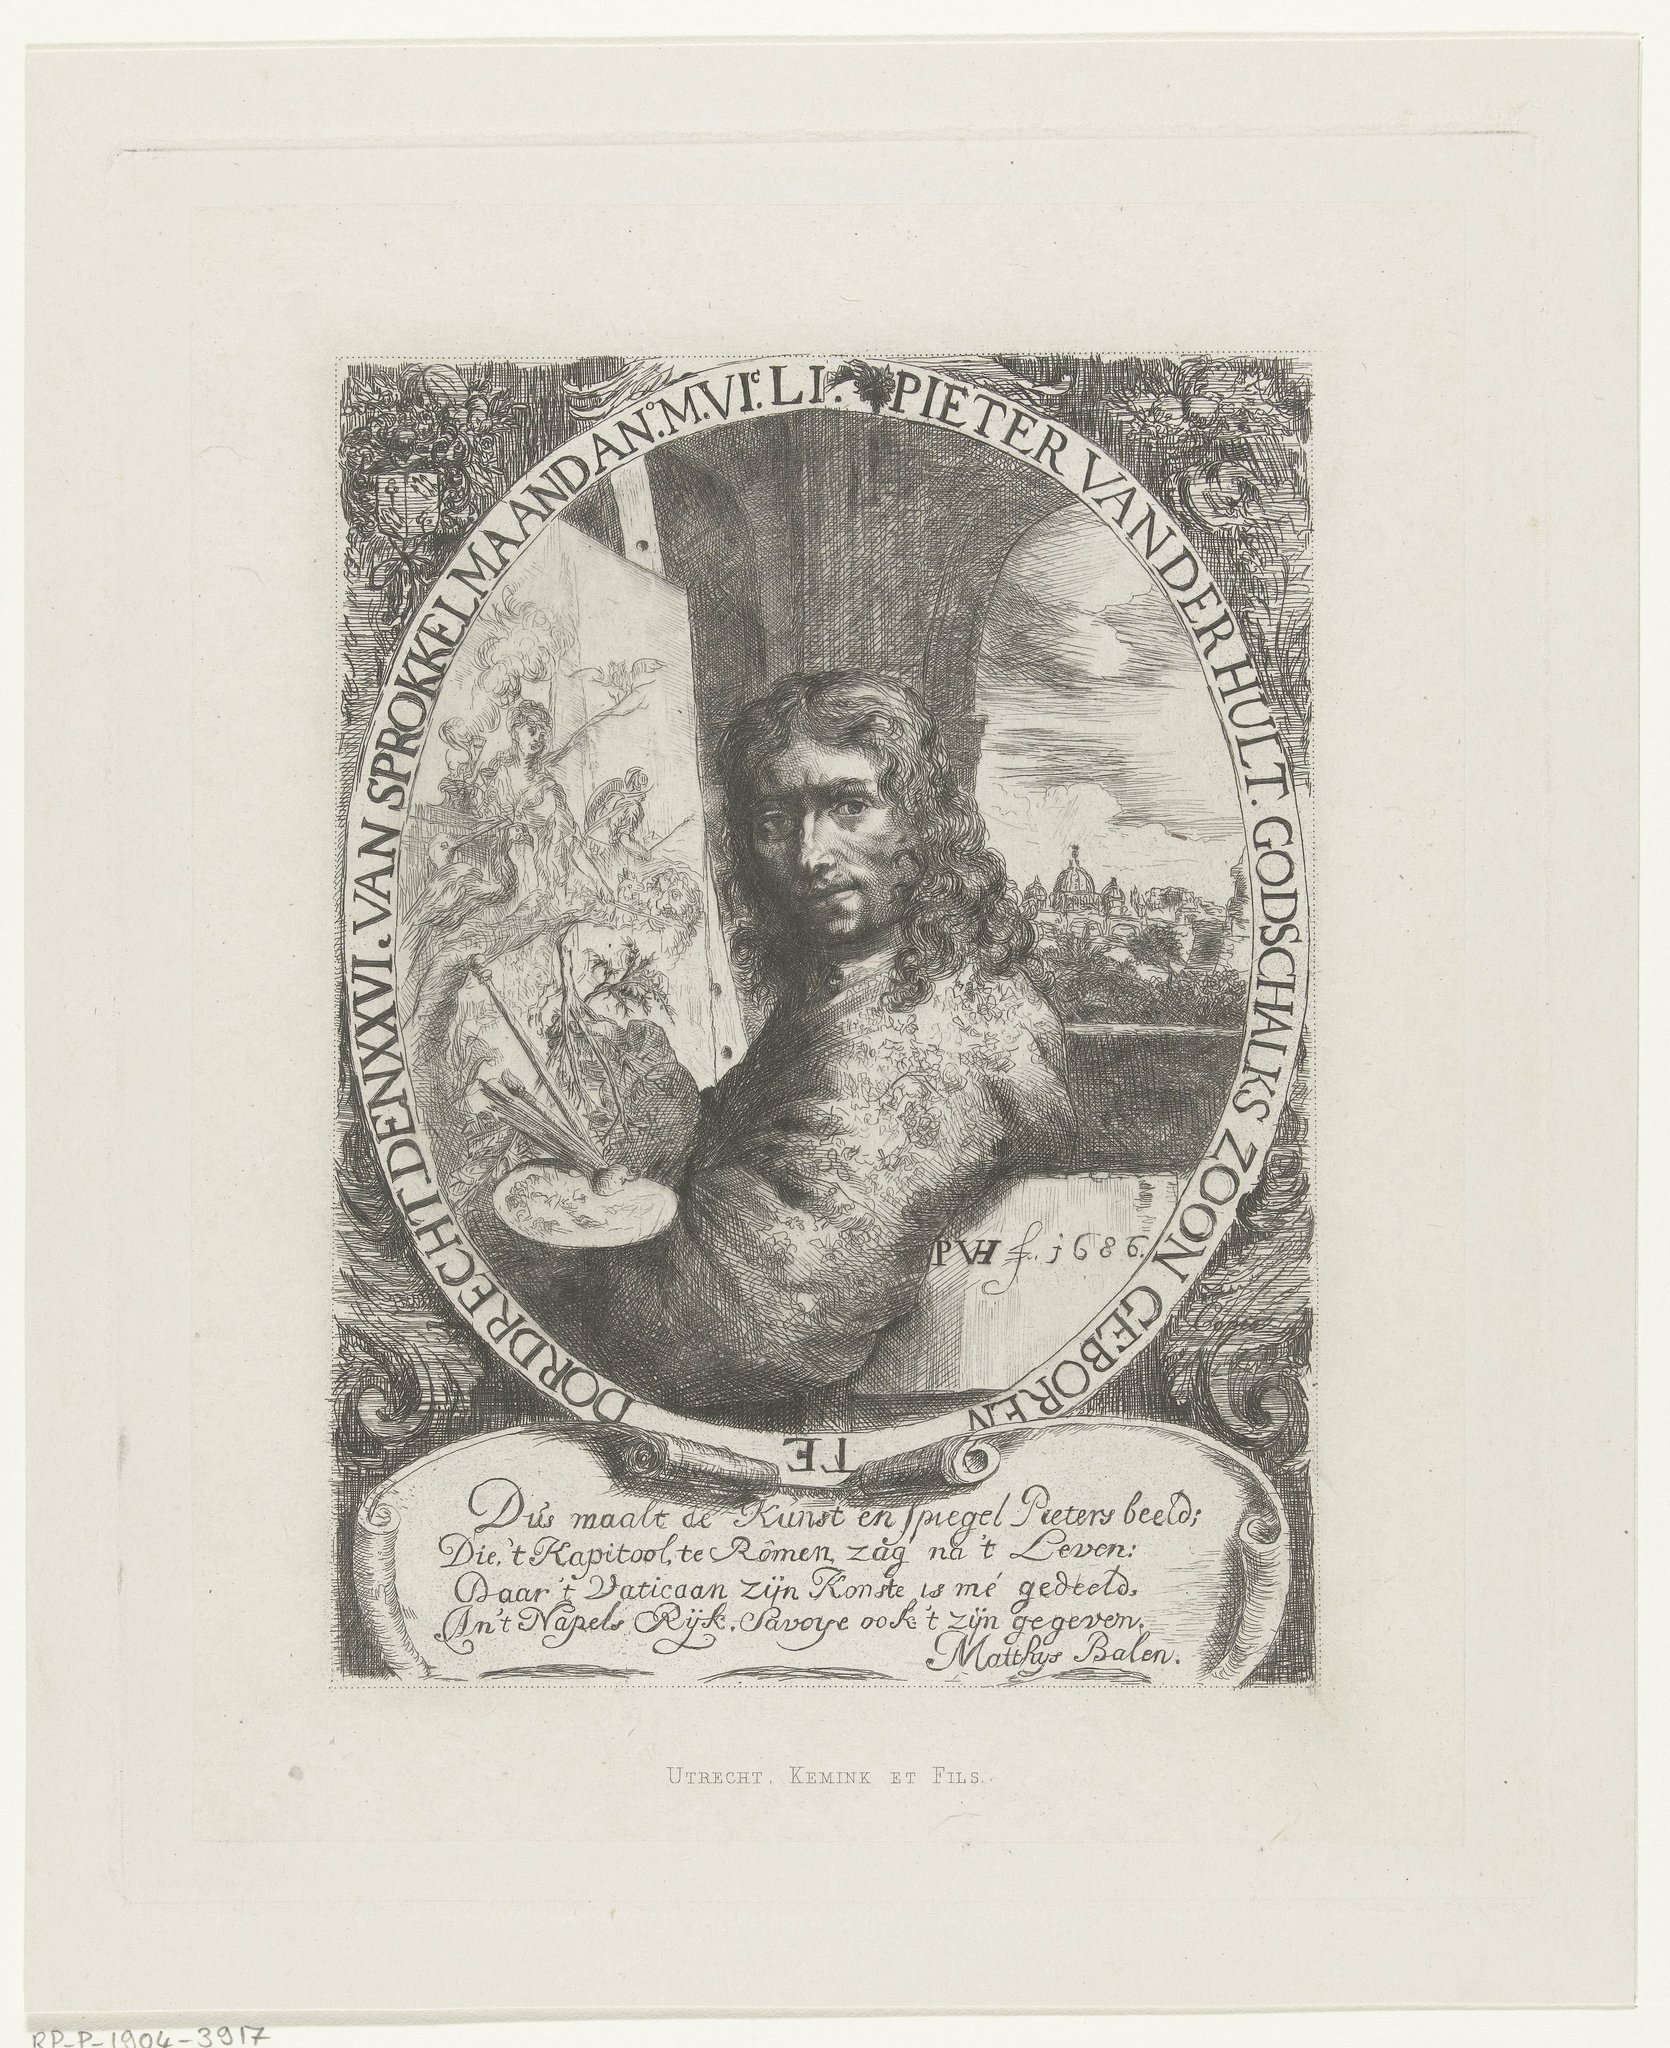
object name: print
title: Zelfportret van Pieter van der Hulst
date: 1866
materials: paper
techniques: drypoint, etching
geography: utrecht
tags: pieter van der hulst (iv)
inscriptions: collector's mark: Lugt 2228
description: Illustratie uit: J.P. van der Kellen, Le peintre graveur hollandais et flamand, Utrecht: 1866.